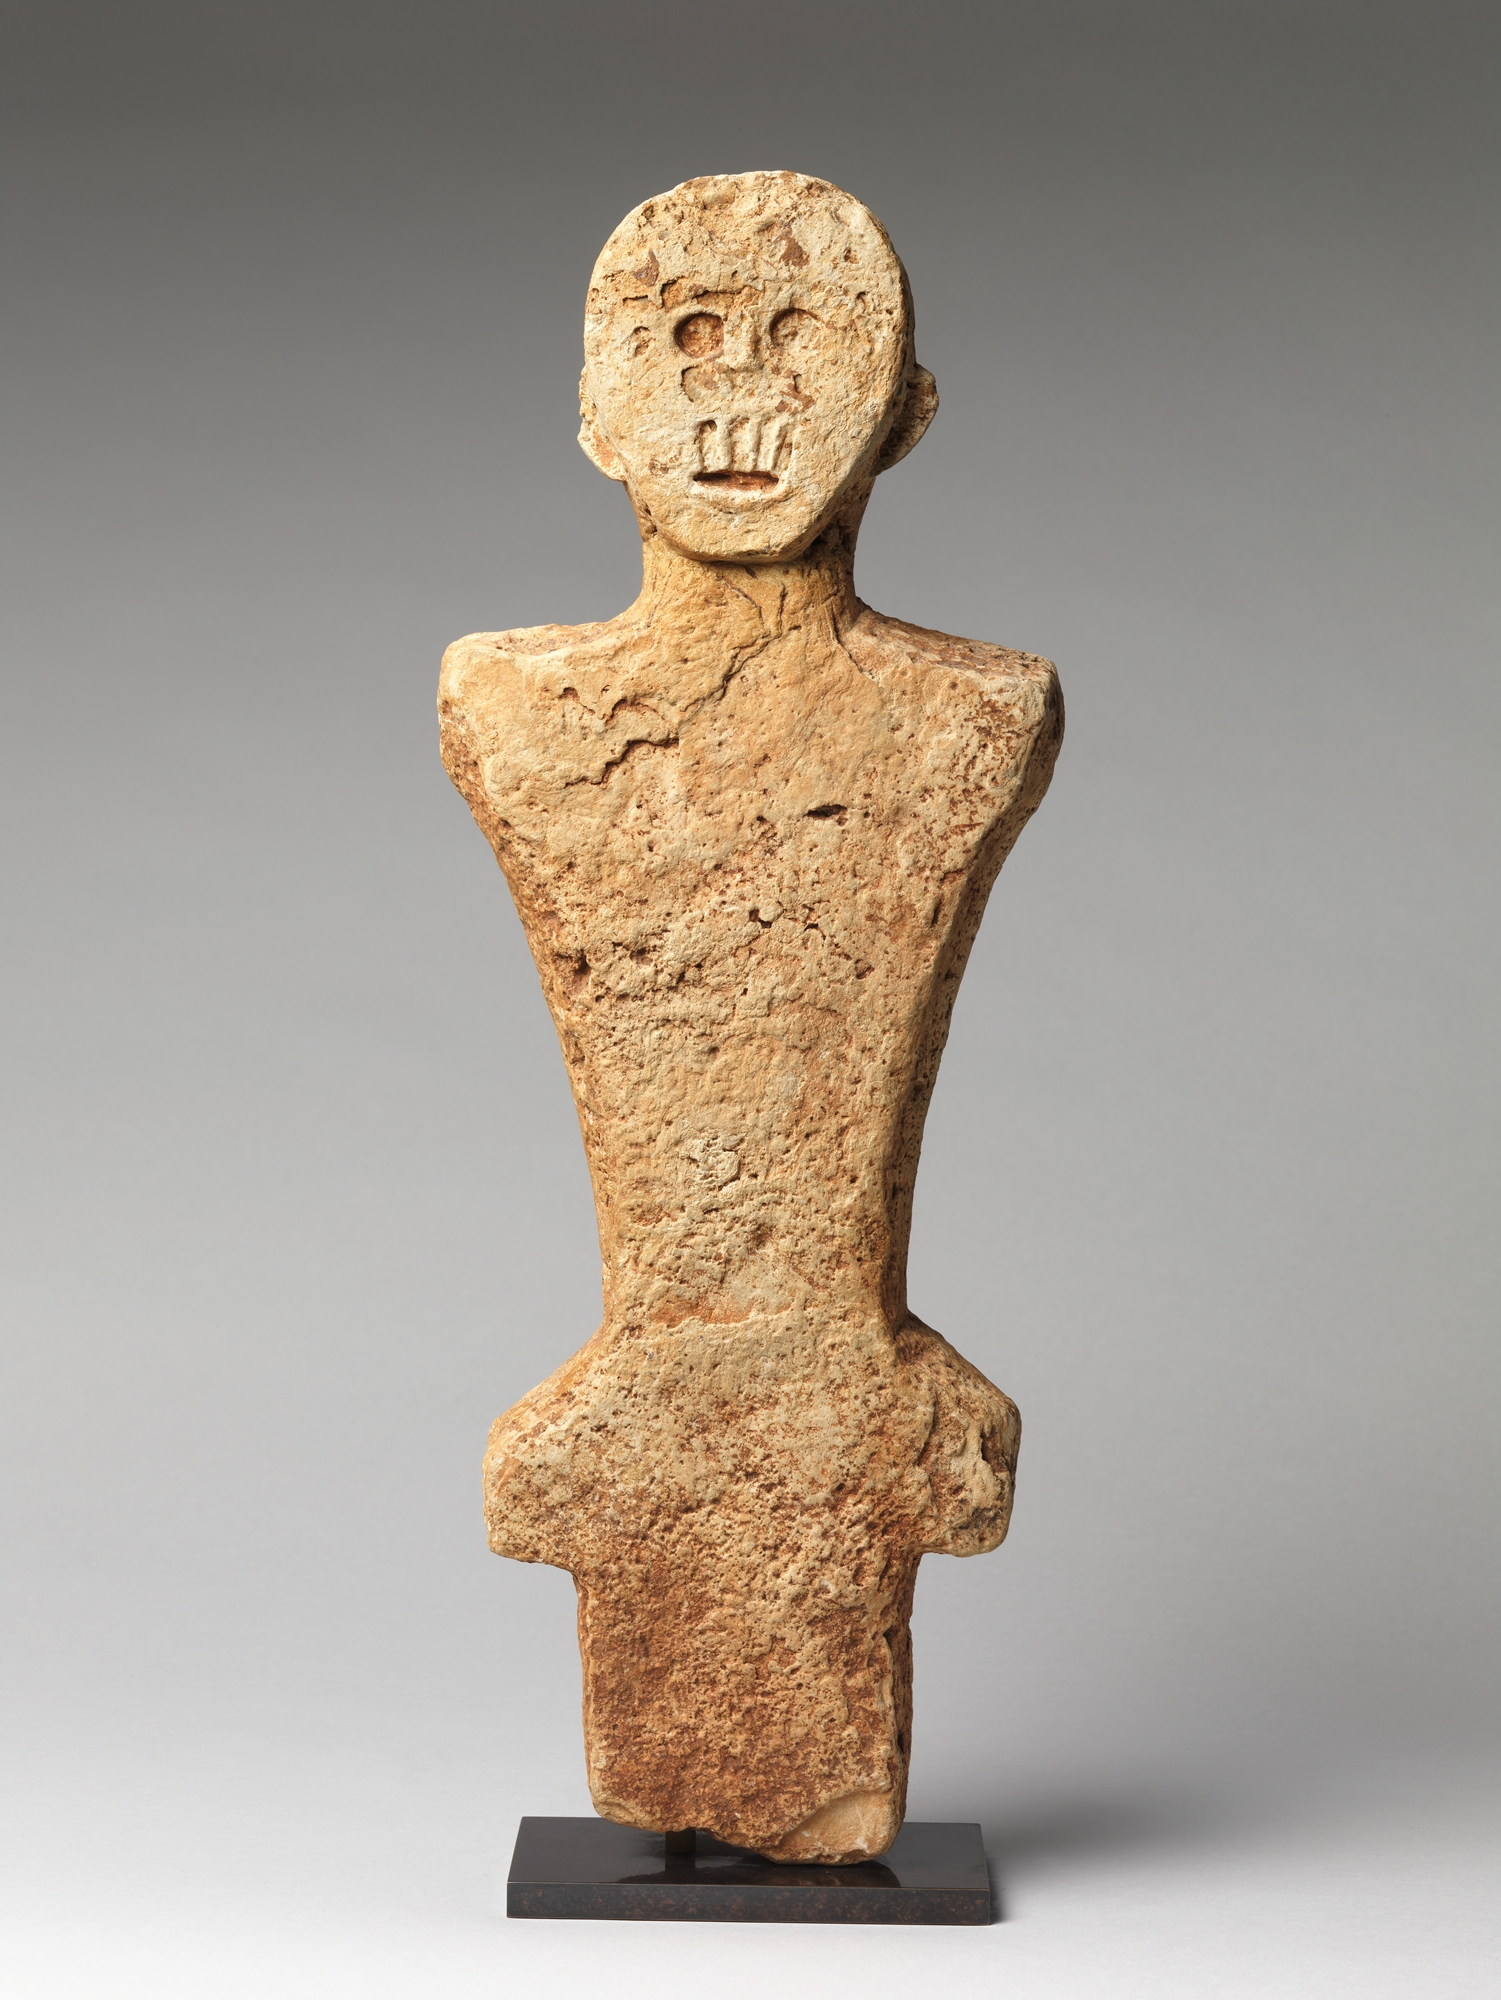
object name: figure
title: Male Anthropomorph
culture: indonesian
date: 500 BCE-100 CE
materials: stone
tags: men